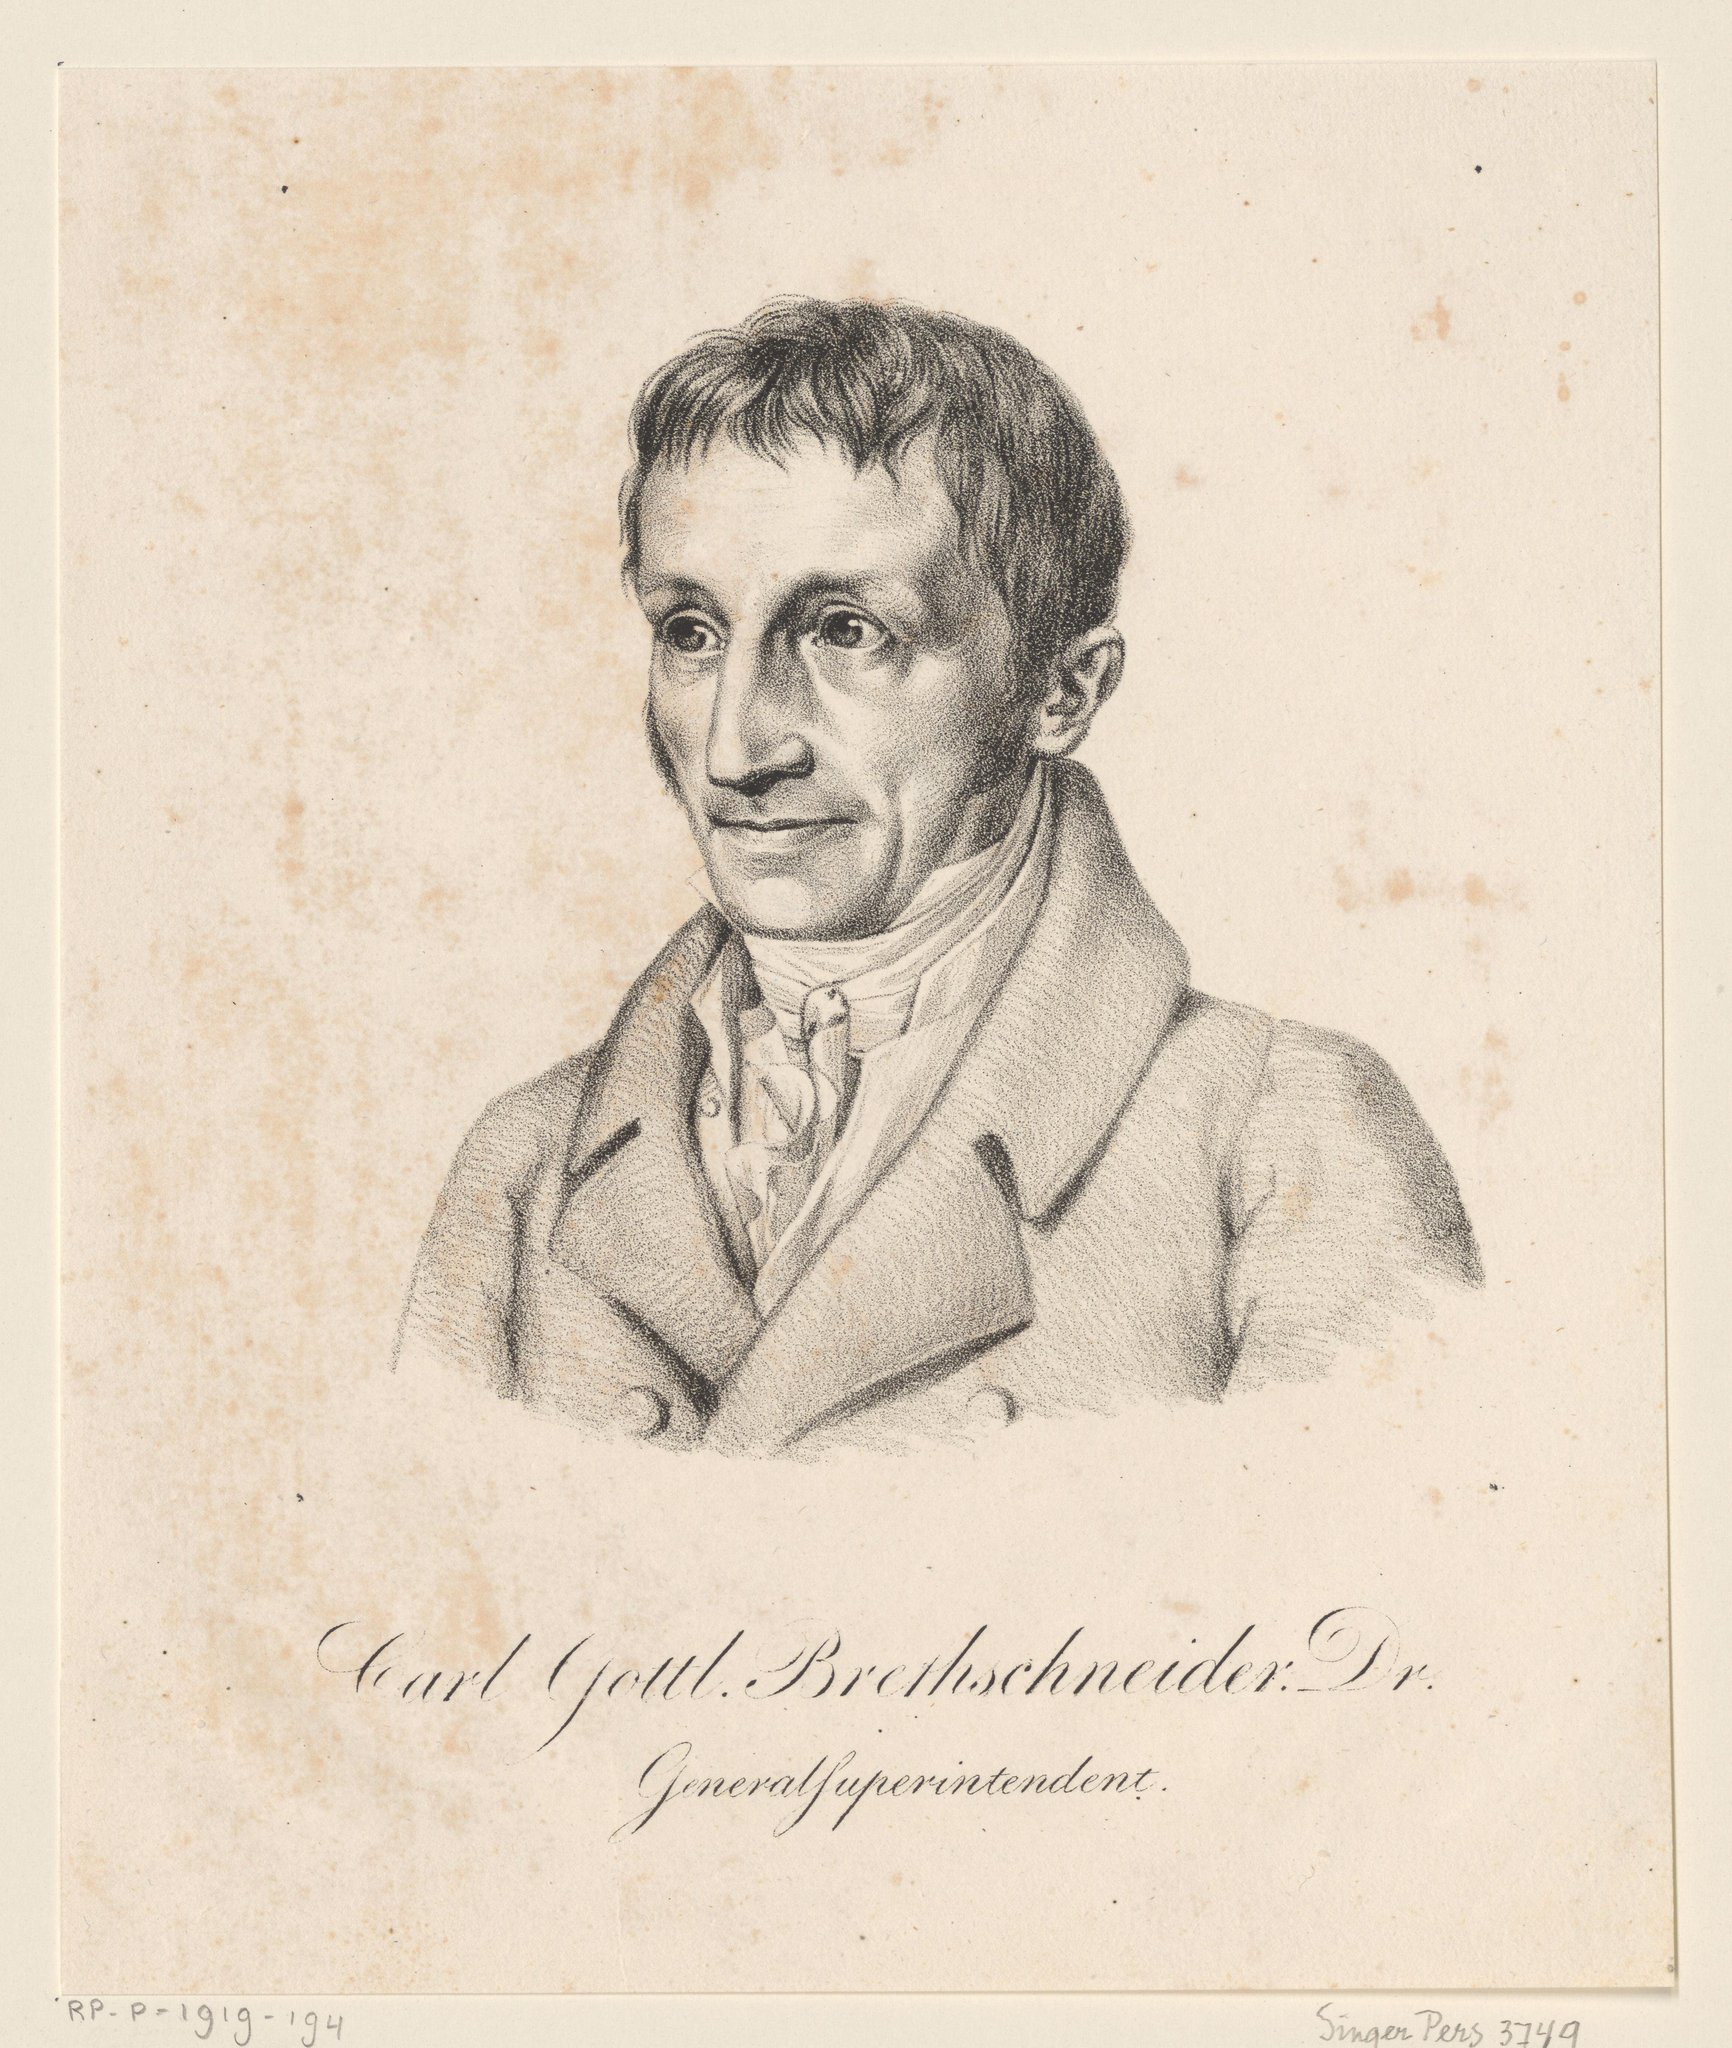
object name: print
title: Portret van Karl Gottlieb Bretschneider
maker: Anonymous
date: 1825-1874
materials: paper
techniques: lithograph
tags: zwickau, theologian, historical persons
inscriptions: collector's mark: Lugt 2228